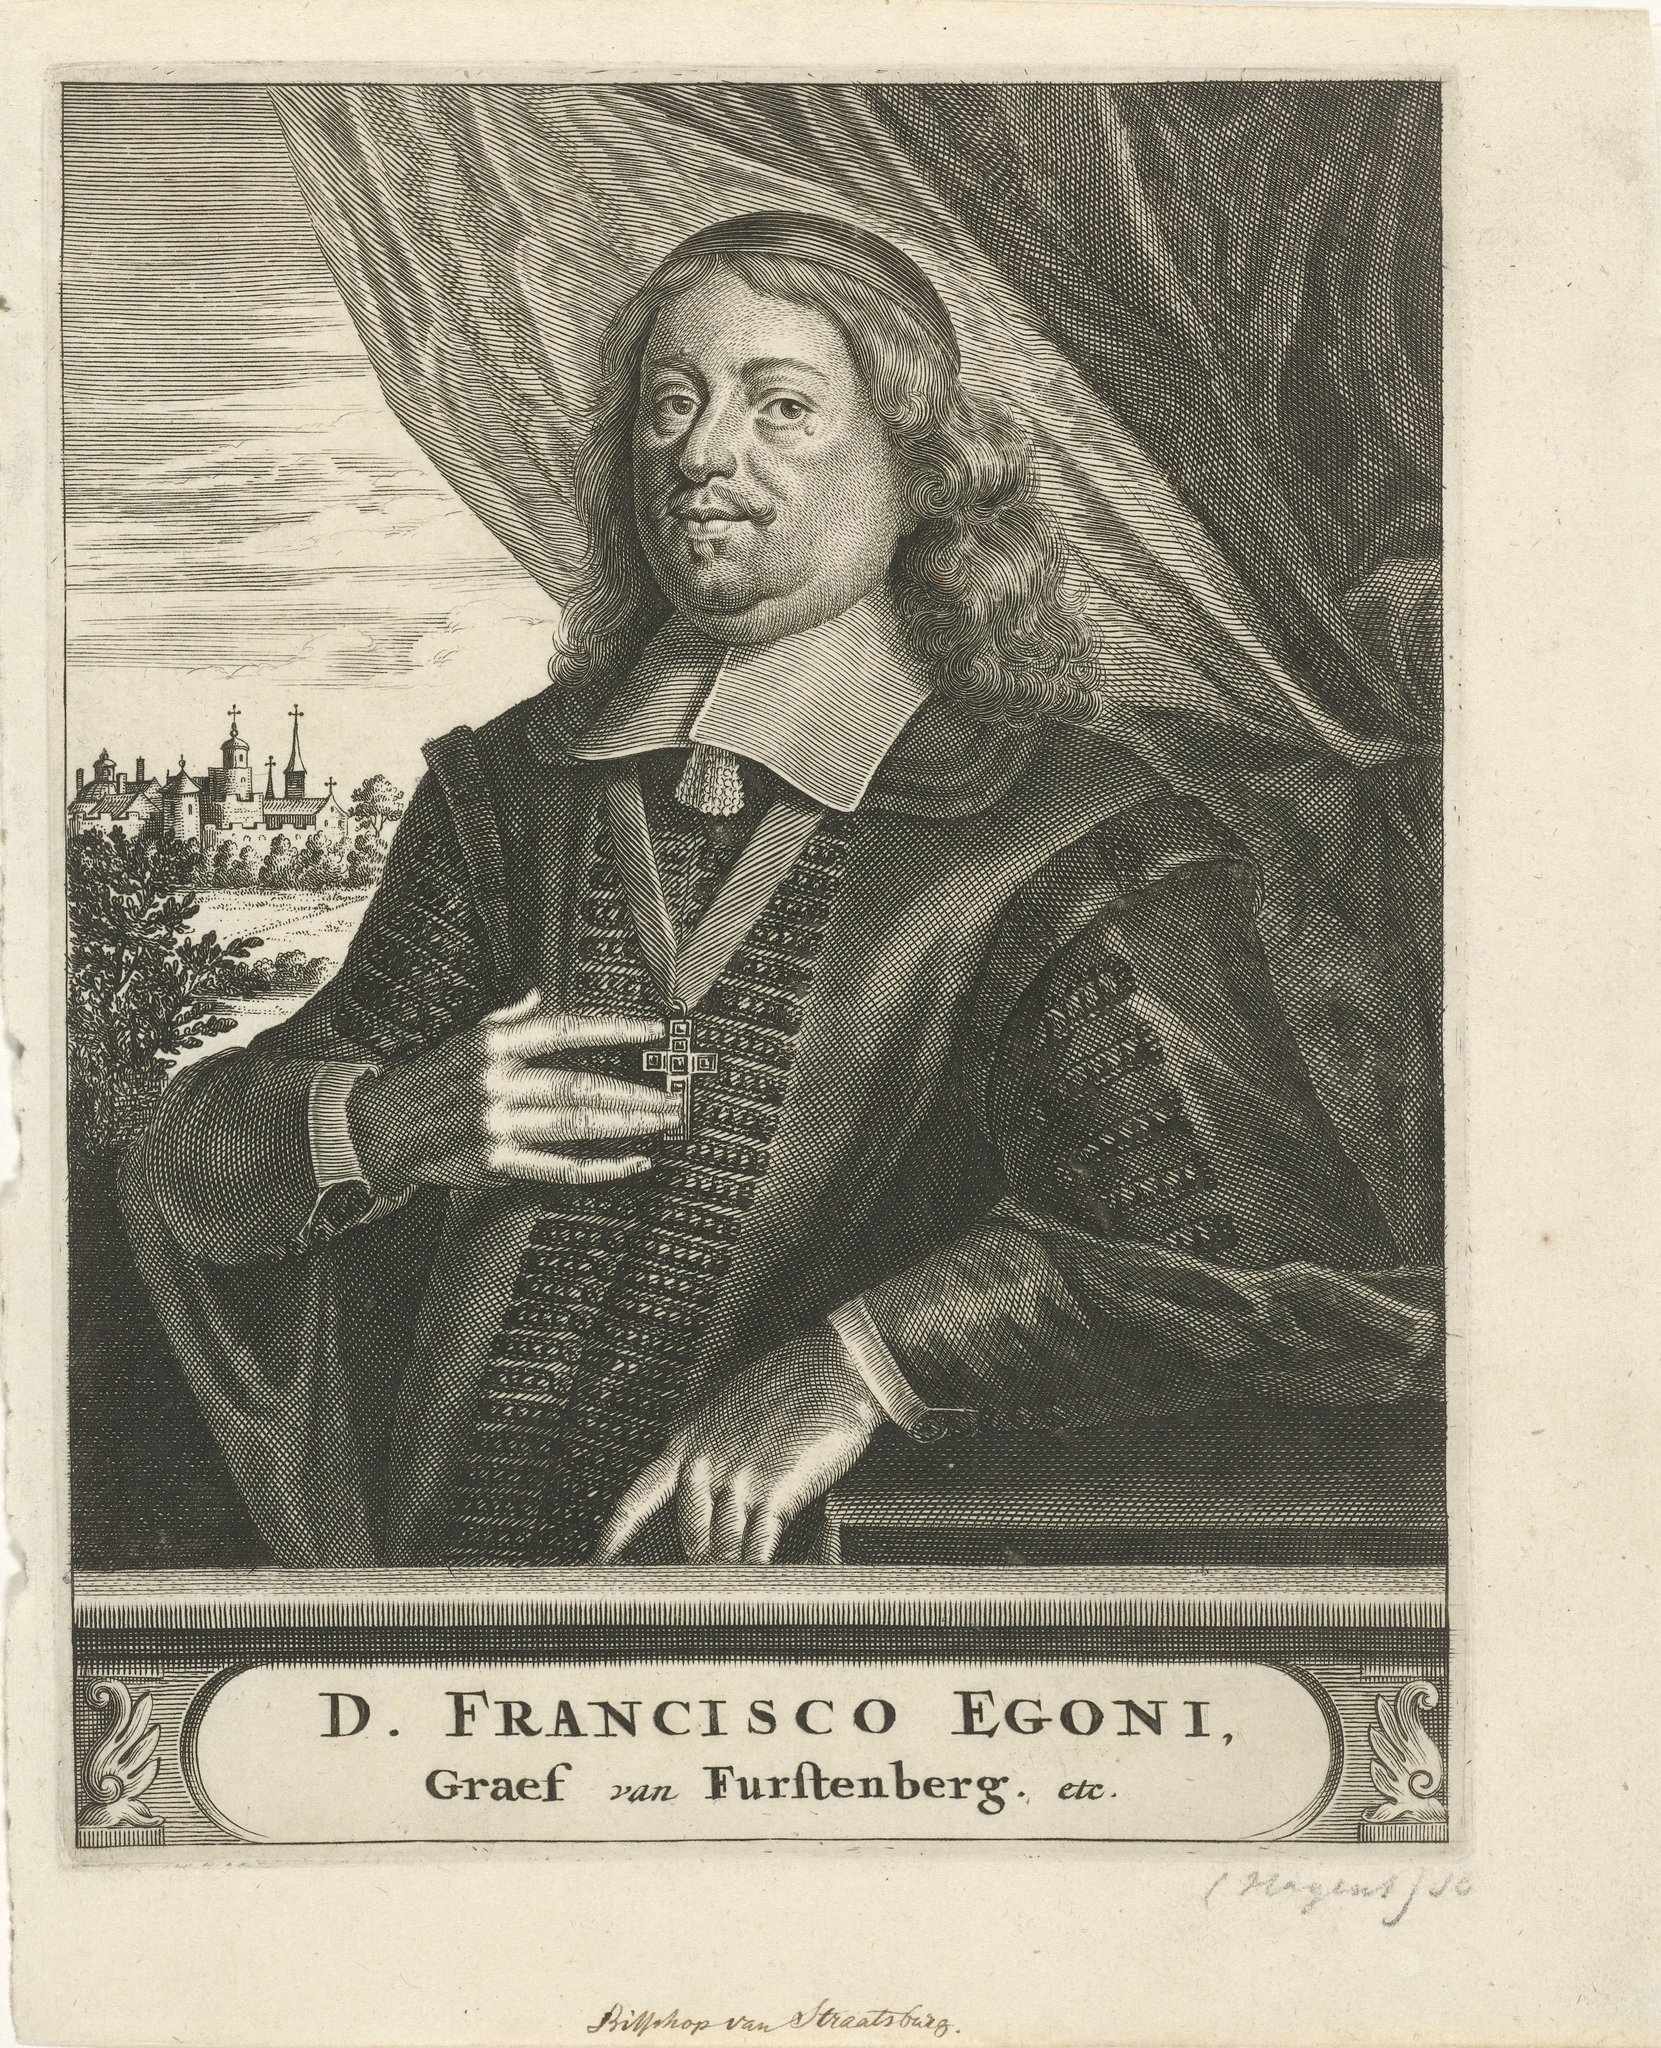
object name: print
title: Portret van Frans Egon, graaf van Fürstenberg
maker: christiaan hagen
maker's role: draughtsman, print maker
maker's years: 1635-1707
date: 1635-1695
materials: paper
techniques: engraving, etching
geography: amsterdam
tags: cologne, head-gear, moustache, necklace (+ men's clothes)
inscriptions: inscription: ‘Bisschop van Straatsburg’, collector's mark: Lugt 2233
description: Portret ten halven lijve naar links van Frans Egon, graaf van Fürstenberg en bisschop van Straatsburg, voor een gordijn, met achter hem een doorkijk op een dorp in een landschap. Onder zijn portret een plint, waarop zijn naam en titel in drie regels in een cartouche.